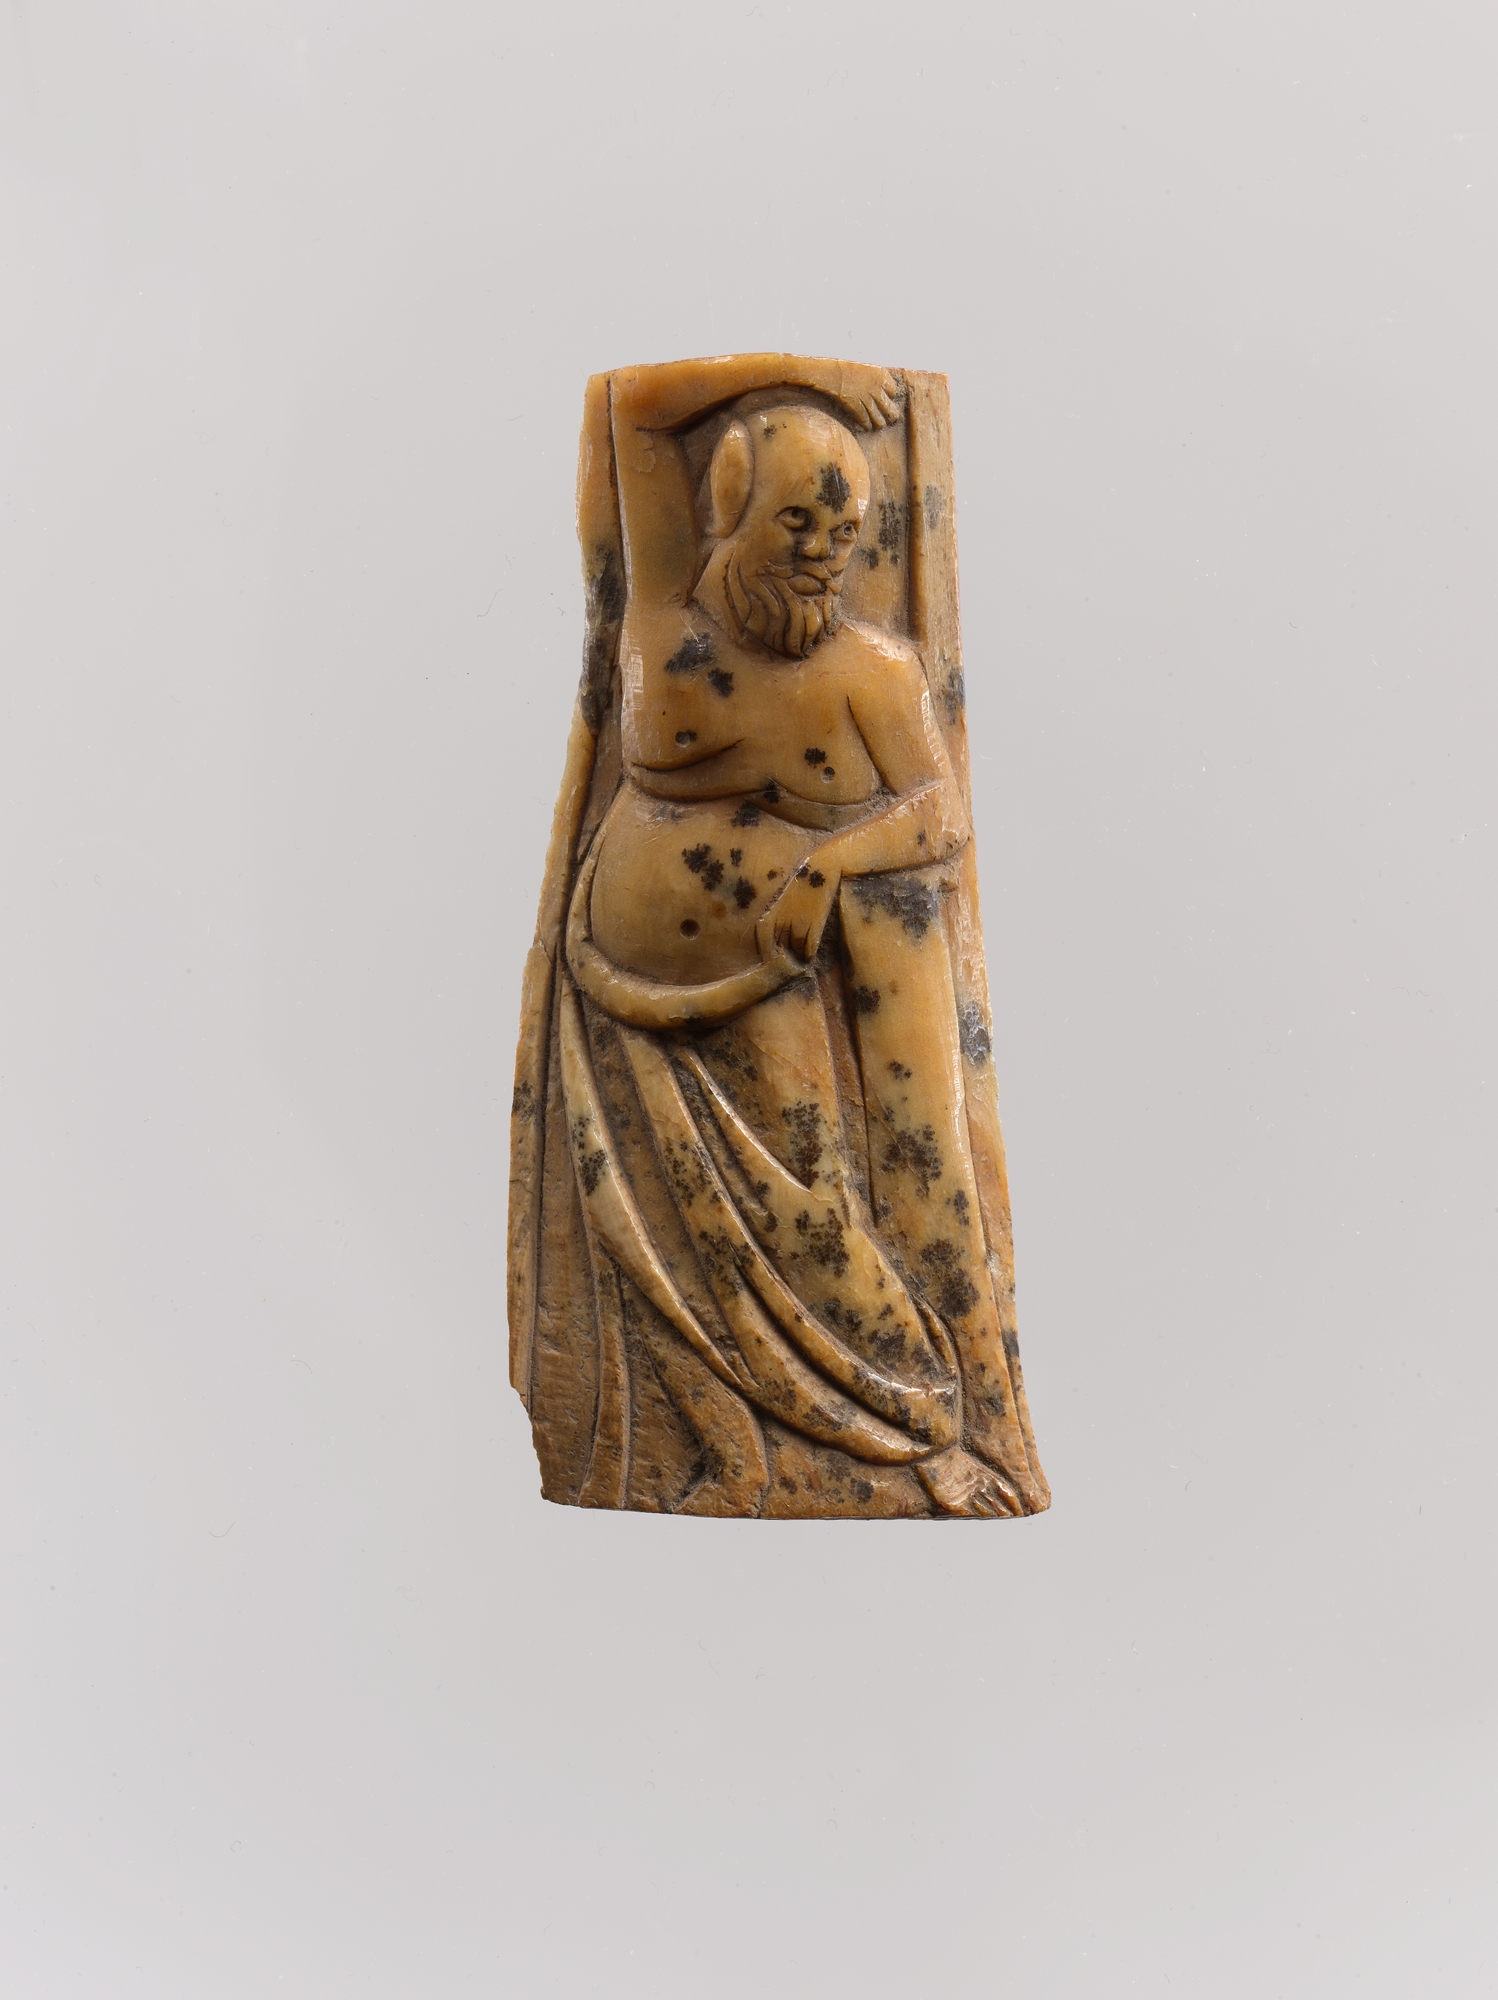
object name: plaque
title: Silenus, the Tutor of Dionysos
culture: byzantine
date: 301-700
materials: bone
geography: egypt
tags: silenus